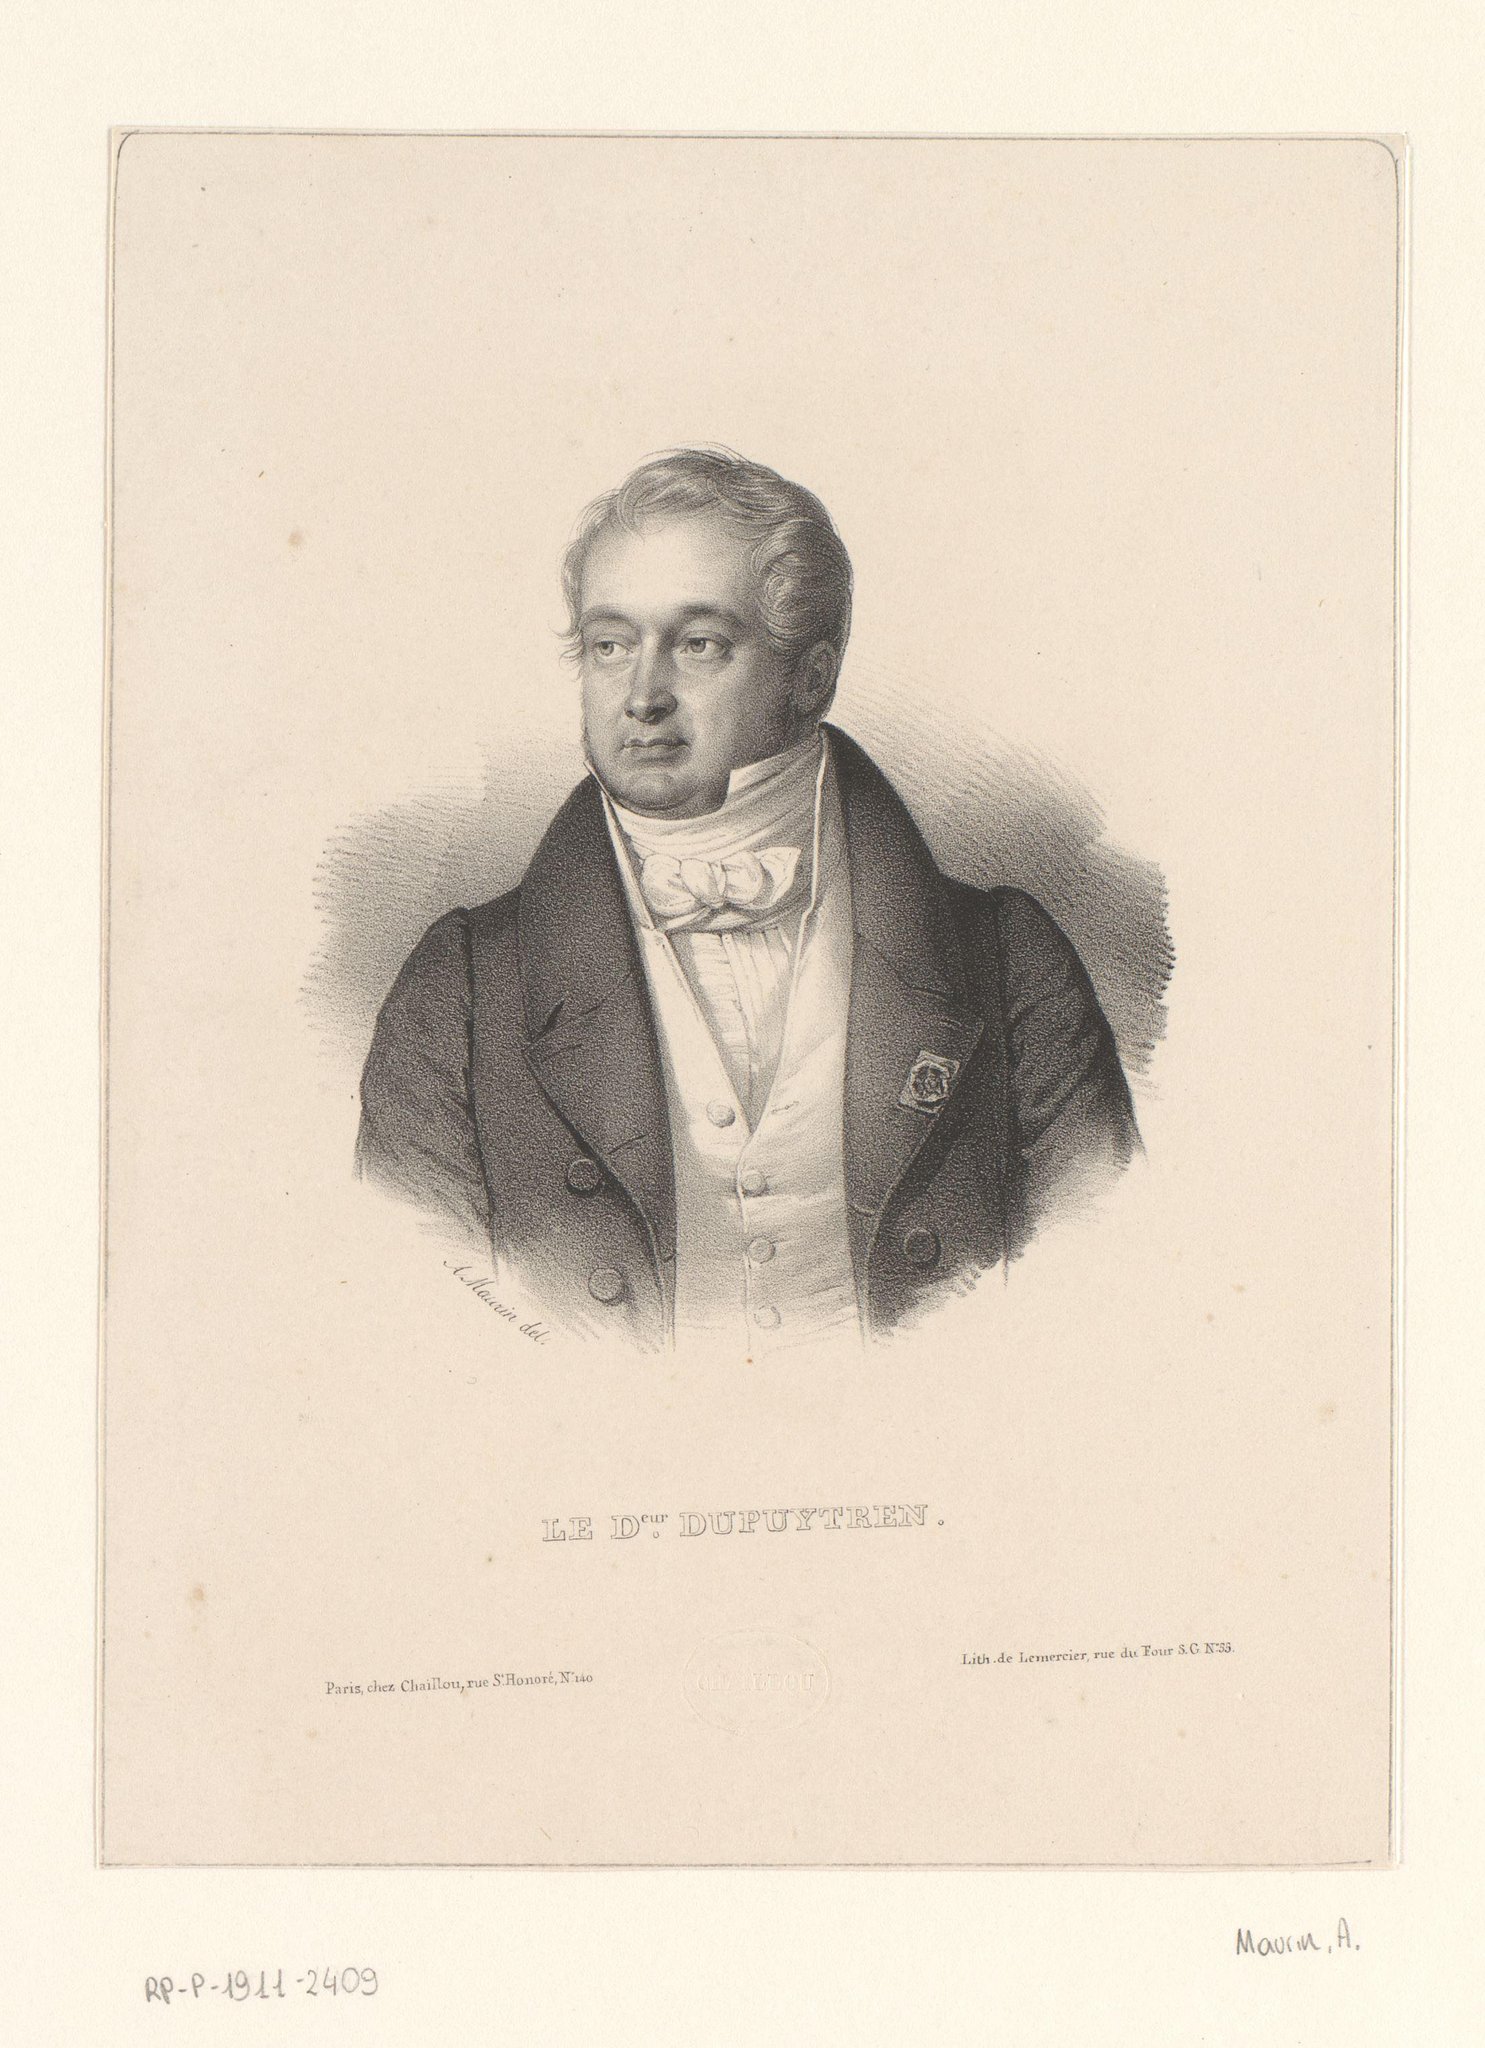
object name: print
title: Portret van arts Guillaume Dupuytren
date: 1828-1838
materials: paper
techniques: lithograph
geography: paris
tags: historical persons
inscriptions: check stamp: Lugt 4733, collector's mark: Lugt 2228